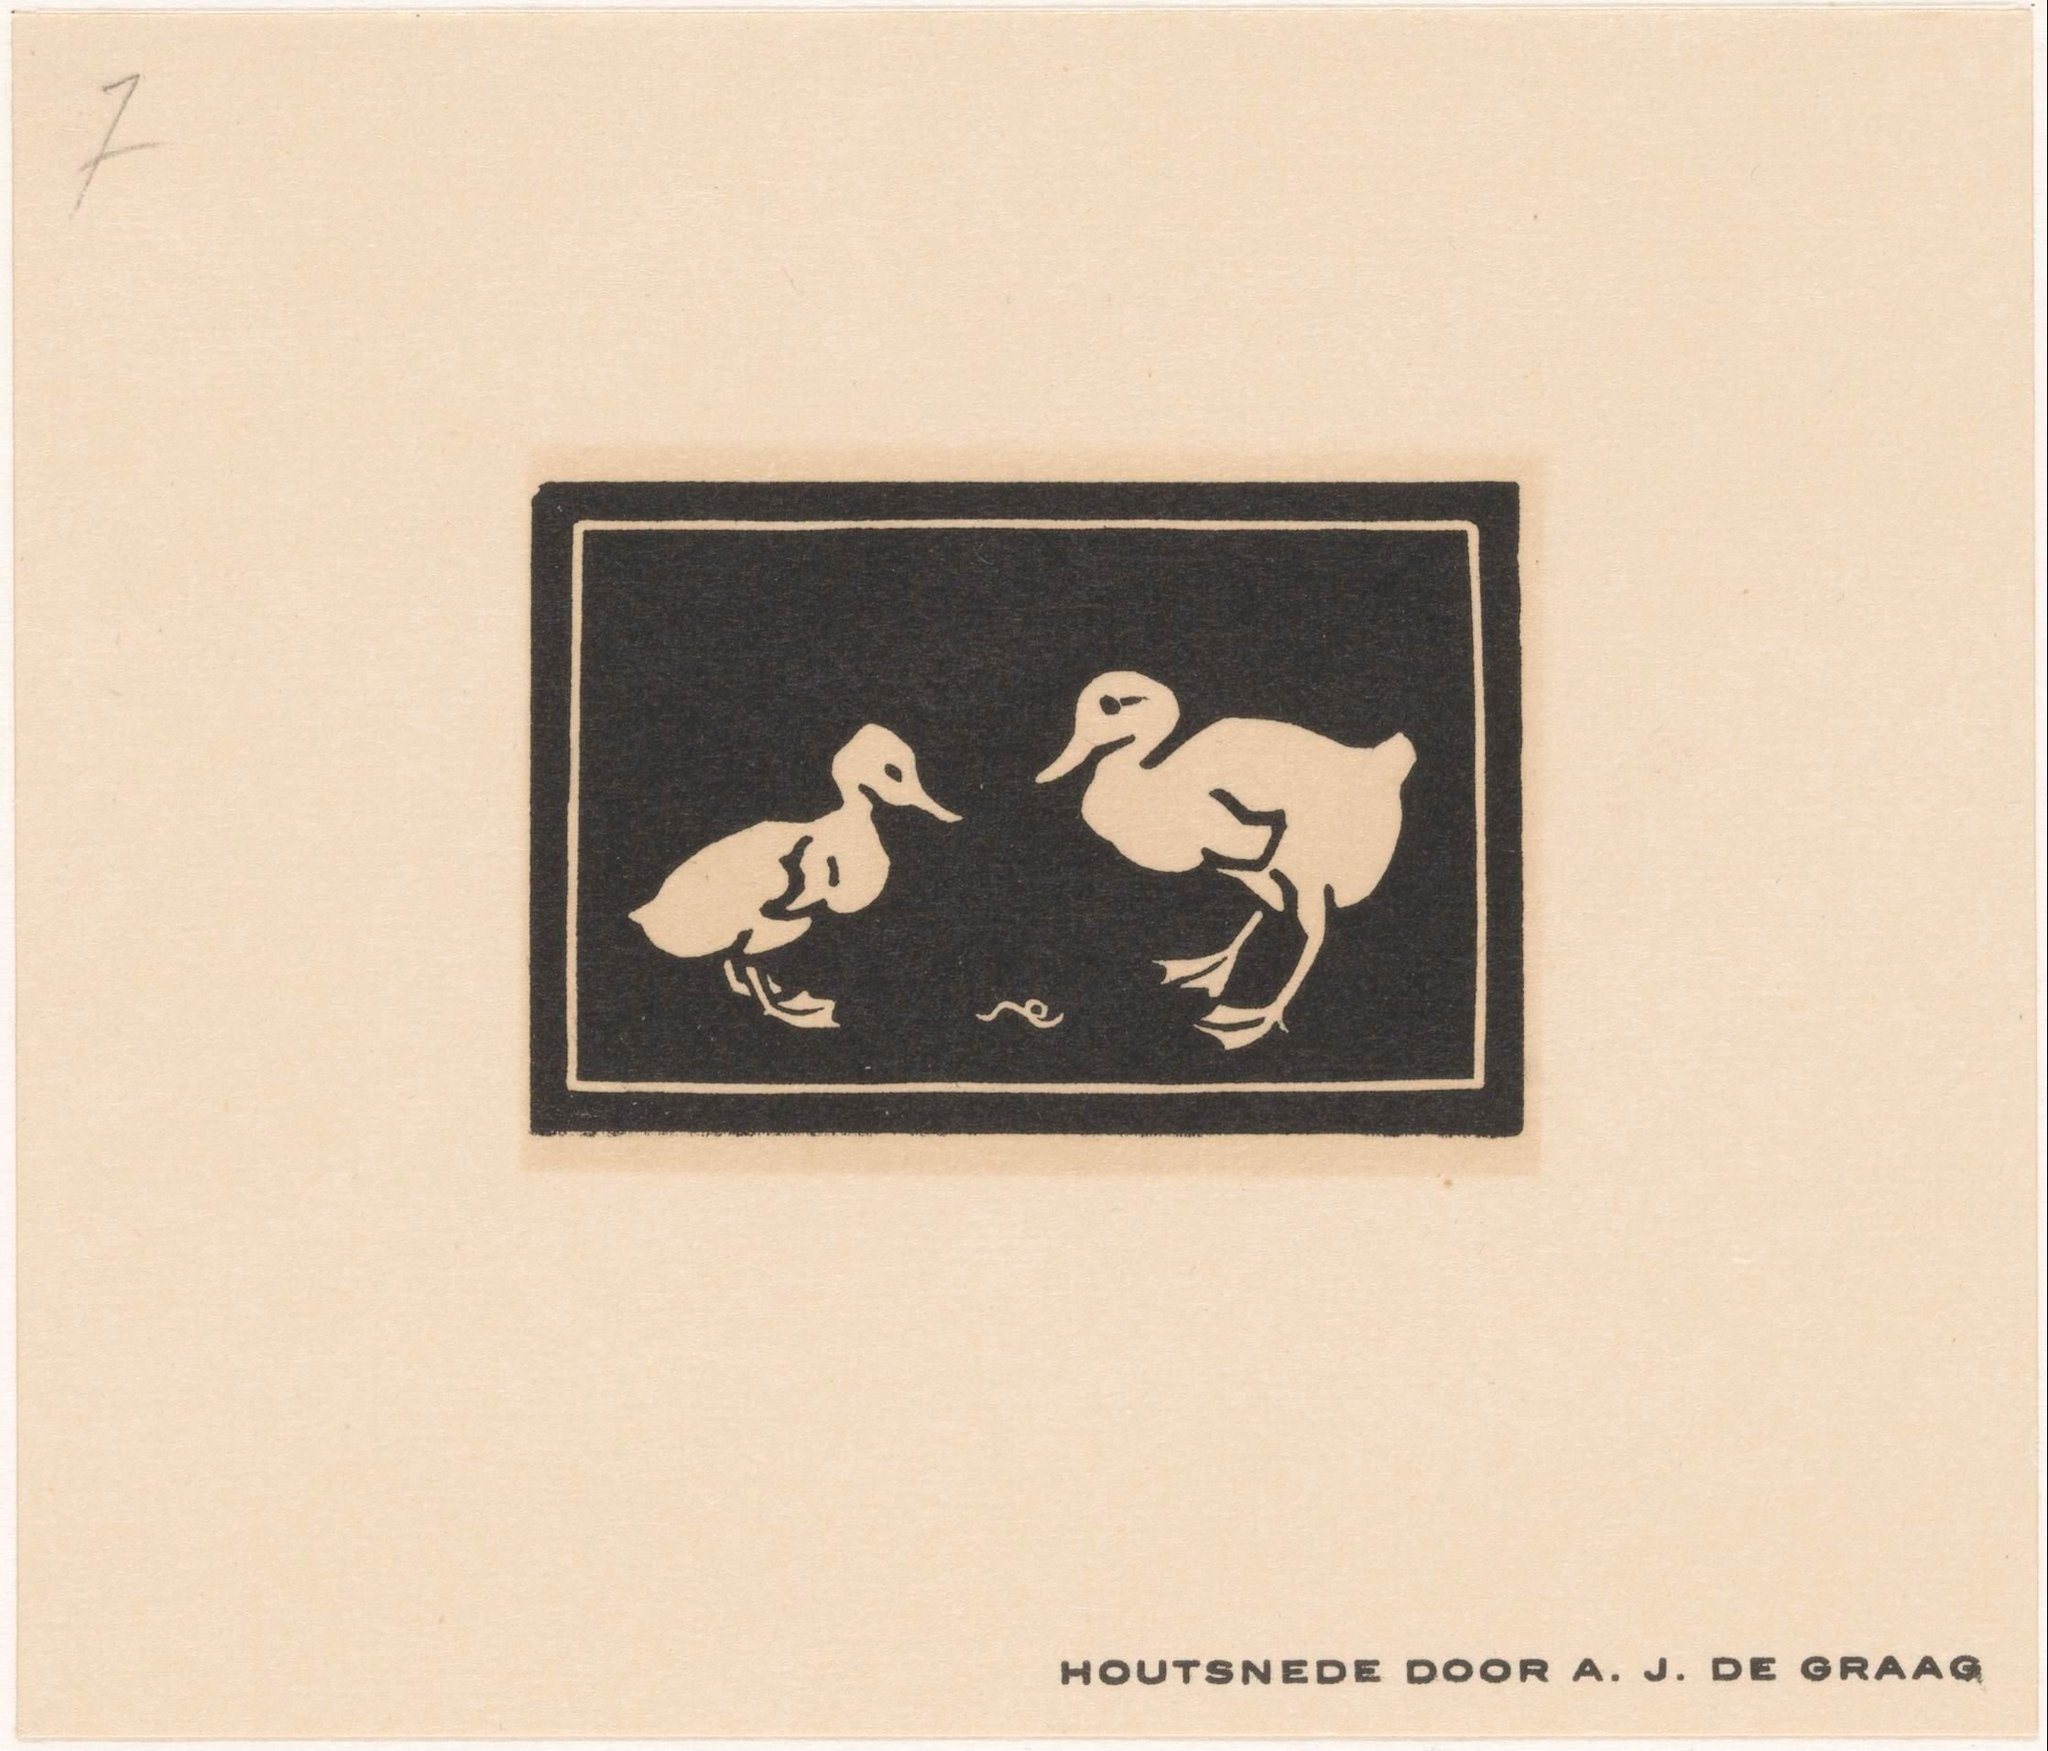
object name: print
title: Twee eendenkuikens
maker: julie de graag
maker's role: draughtsman, print maker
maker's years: 1877-1924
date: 1923-1924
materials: paper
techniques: woodcut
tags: water-birds: duck (+ young animal)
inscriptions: collector's mark: Lugt 2228